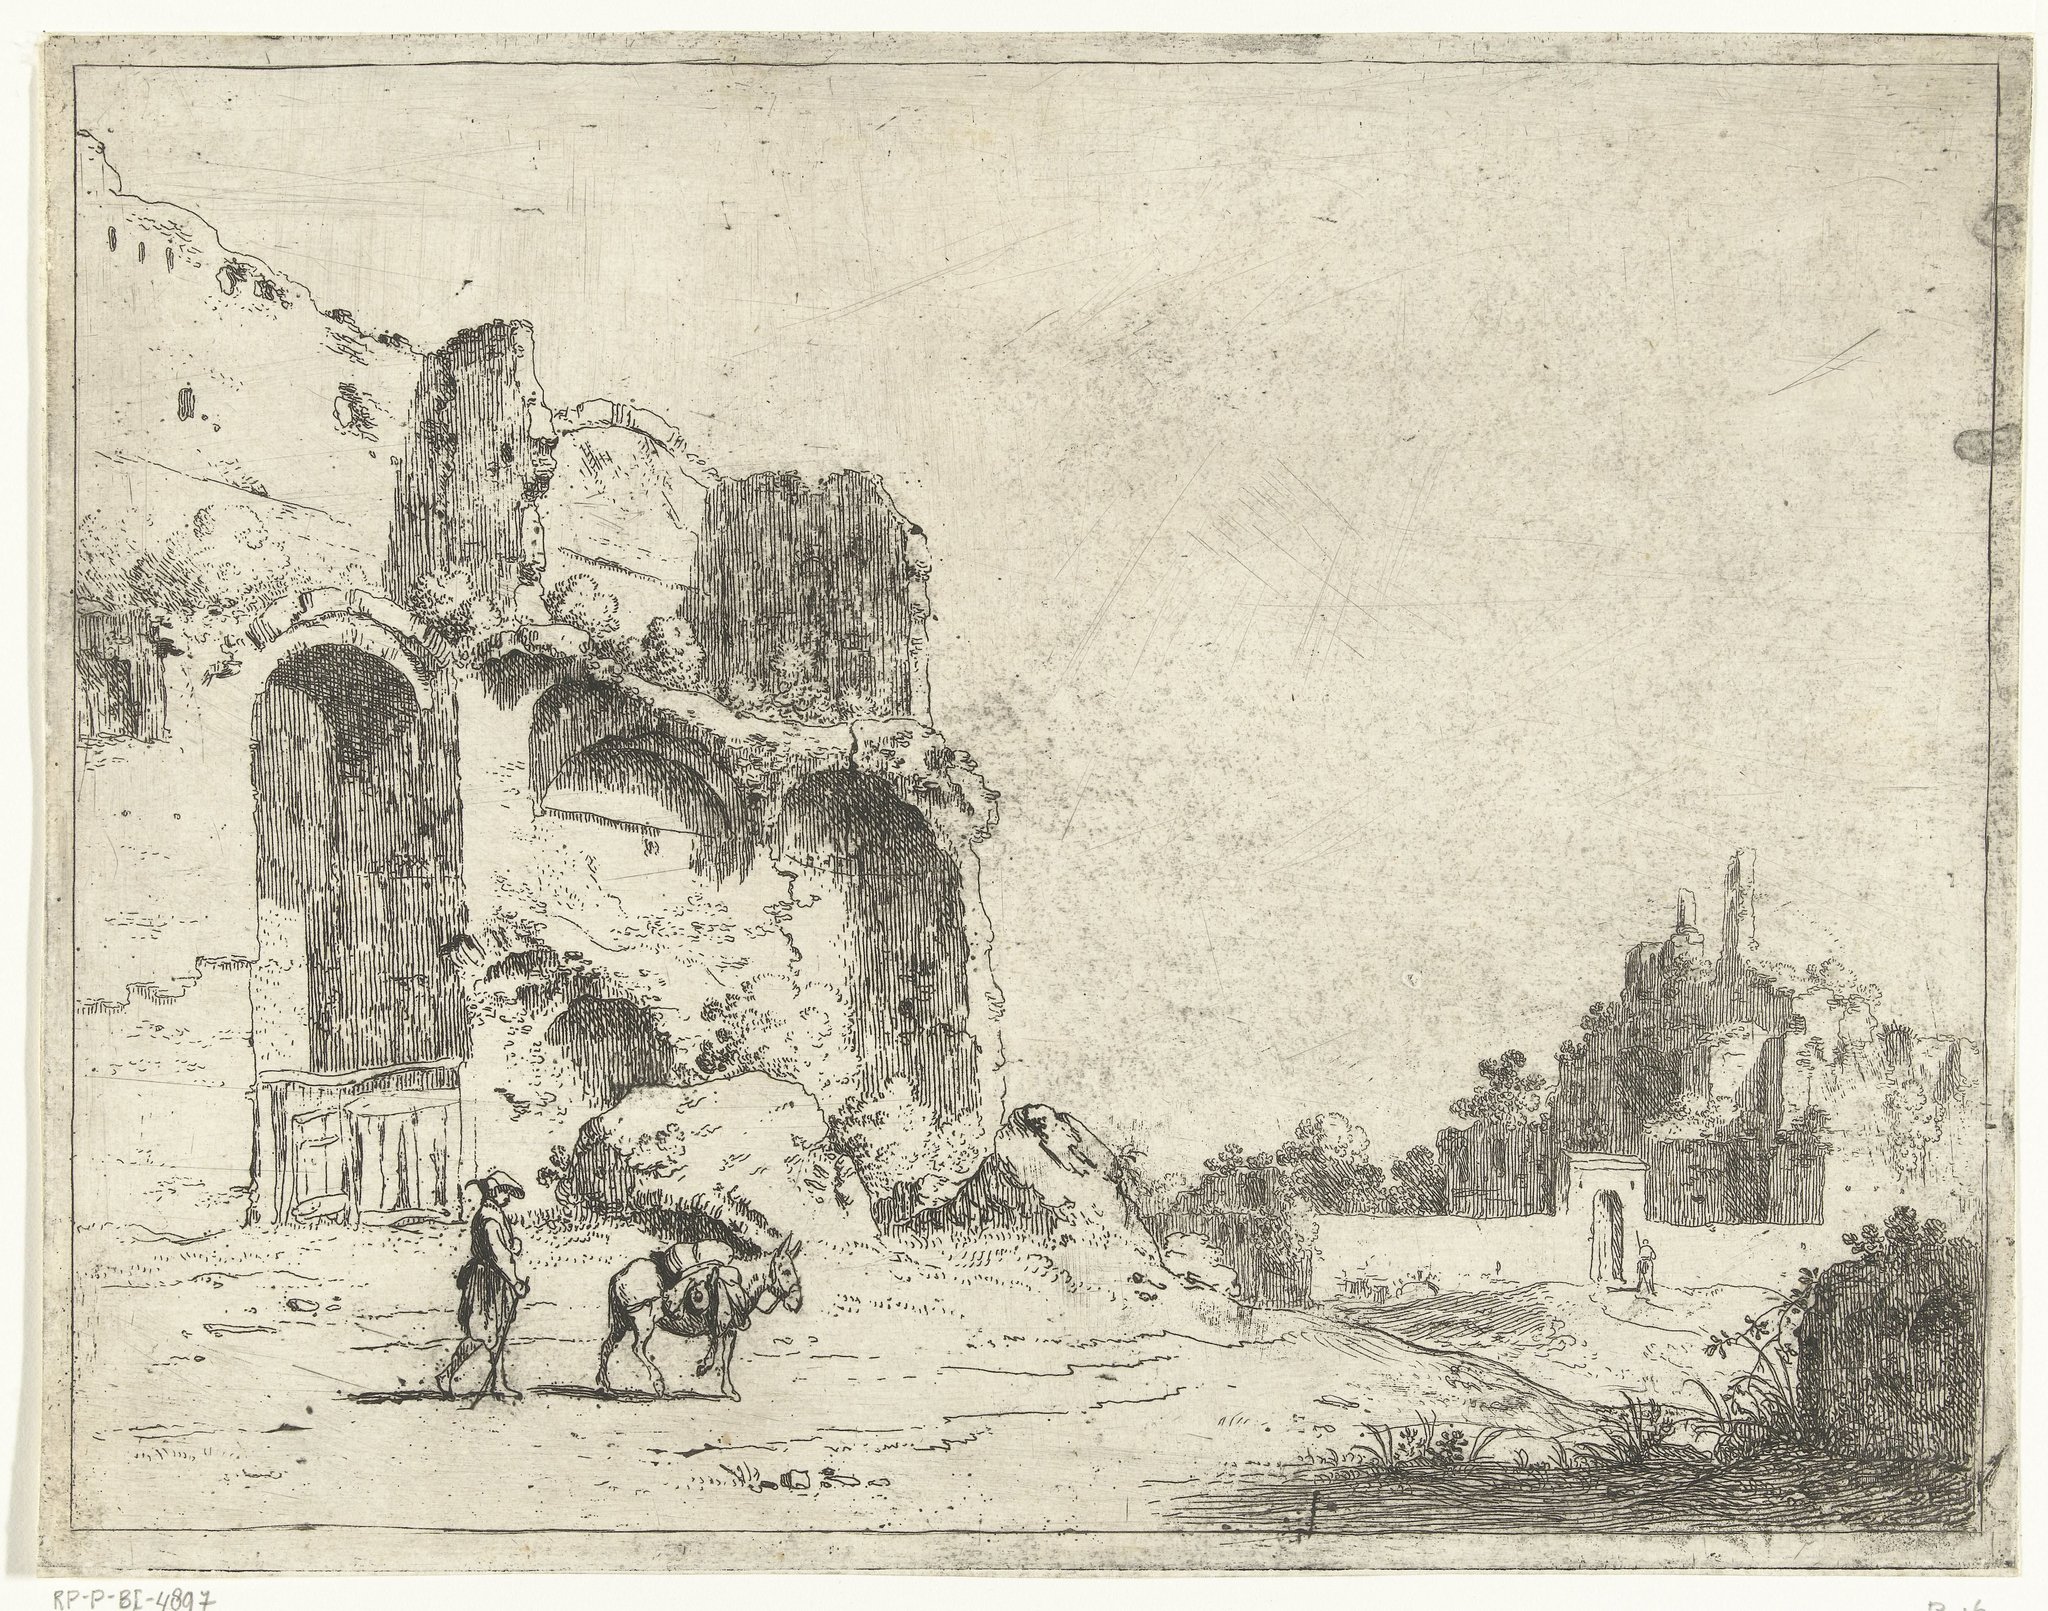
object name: print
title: Romeinse ruïnes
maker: jan gerritsz. van bronckhorst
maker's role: draughtsman, painter, print maker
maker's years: 1603-1661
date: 1613-1661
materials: paper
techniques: etching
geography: netherlands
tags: ass, donkey, landscape with ruins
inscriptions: collector's mark: Lugt 240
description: Prent naar ontwerp van Cornelis van Poelenburch. Prent uit serie van negen prenten met Romeinse ruïnes.